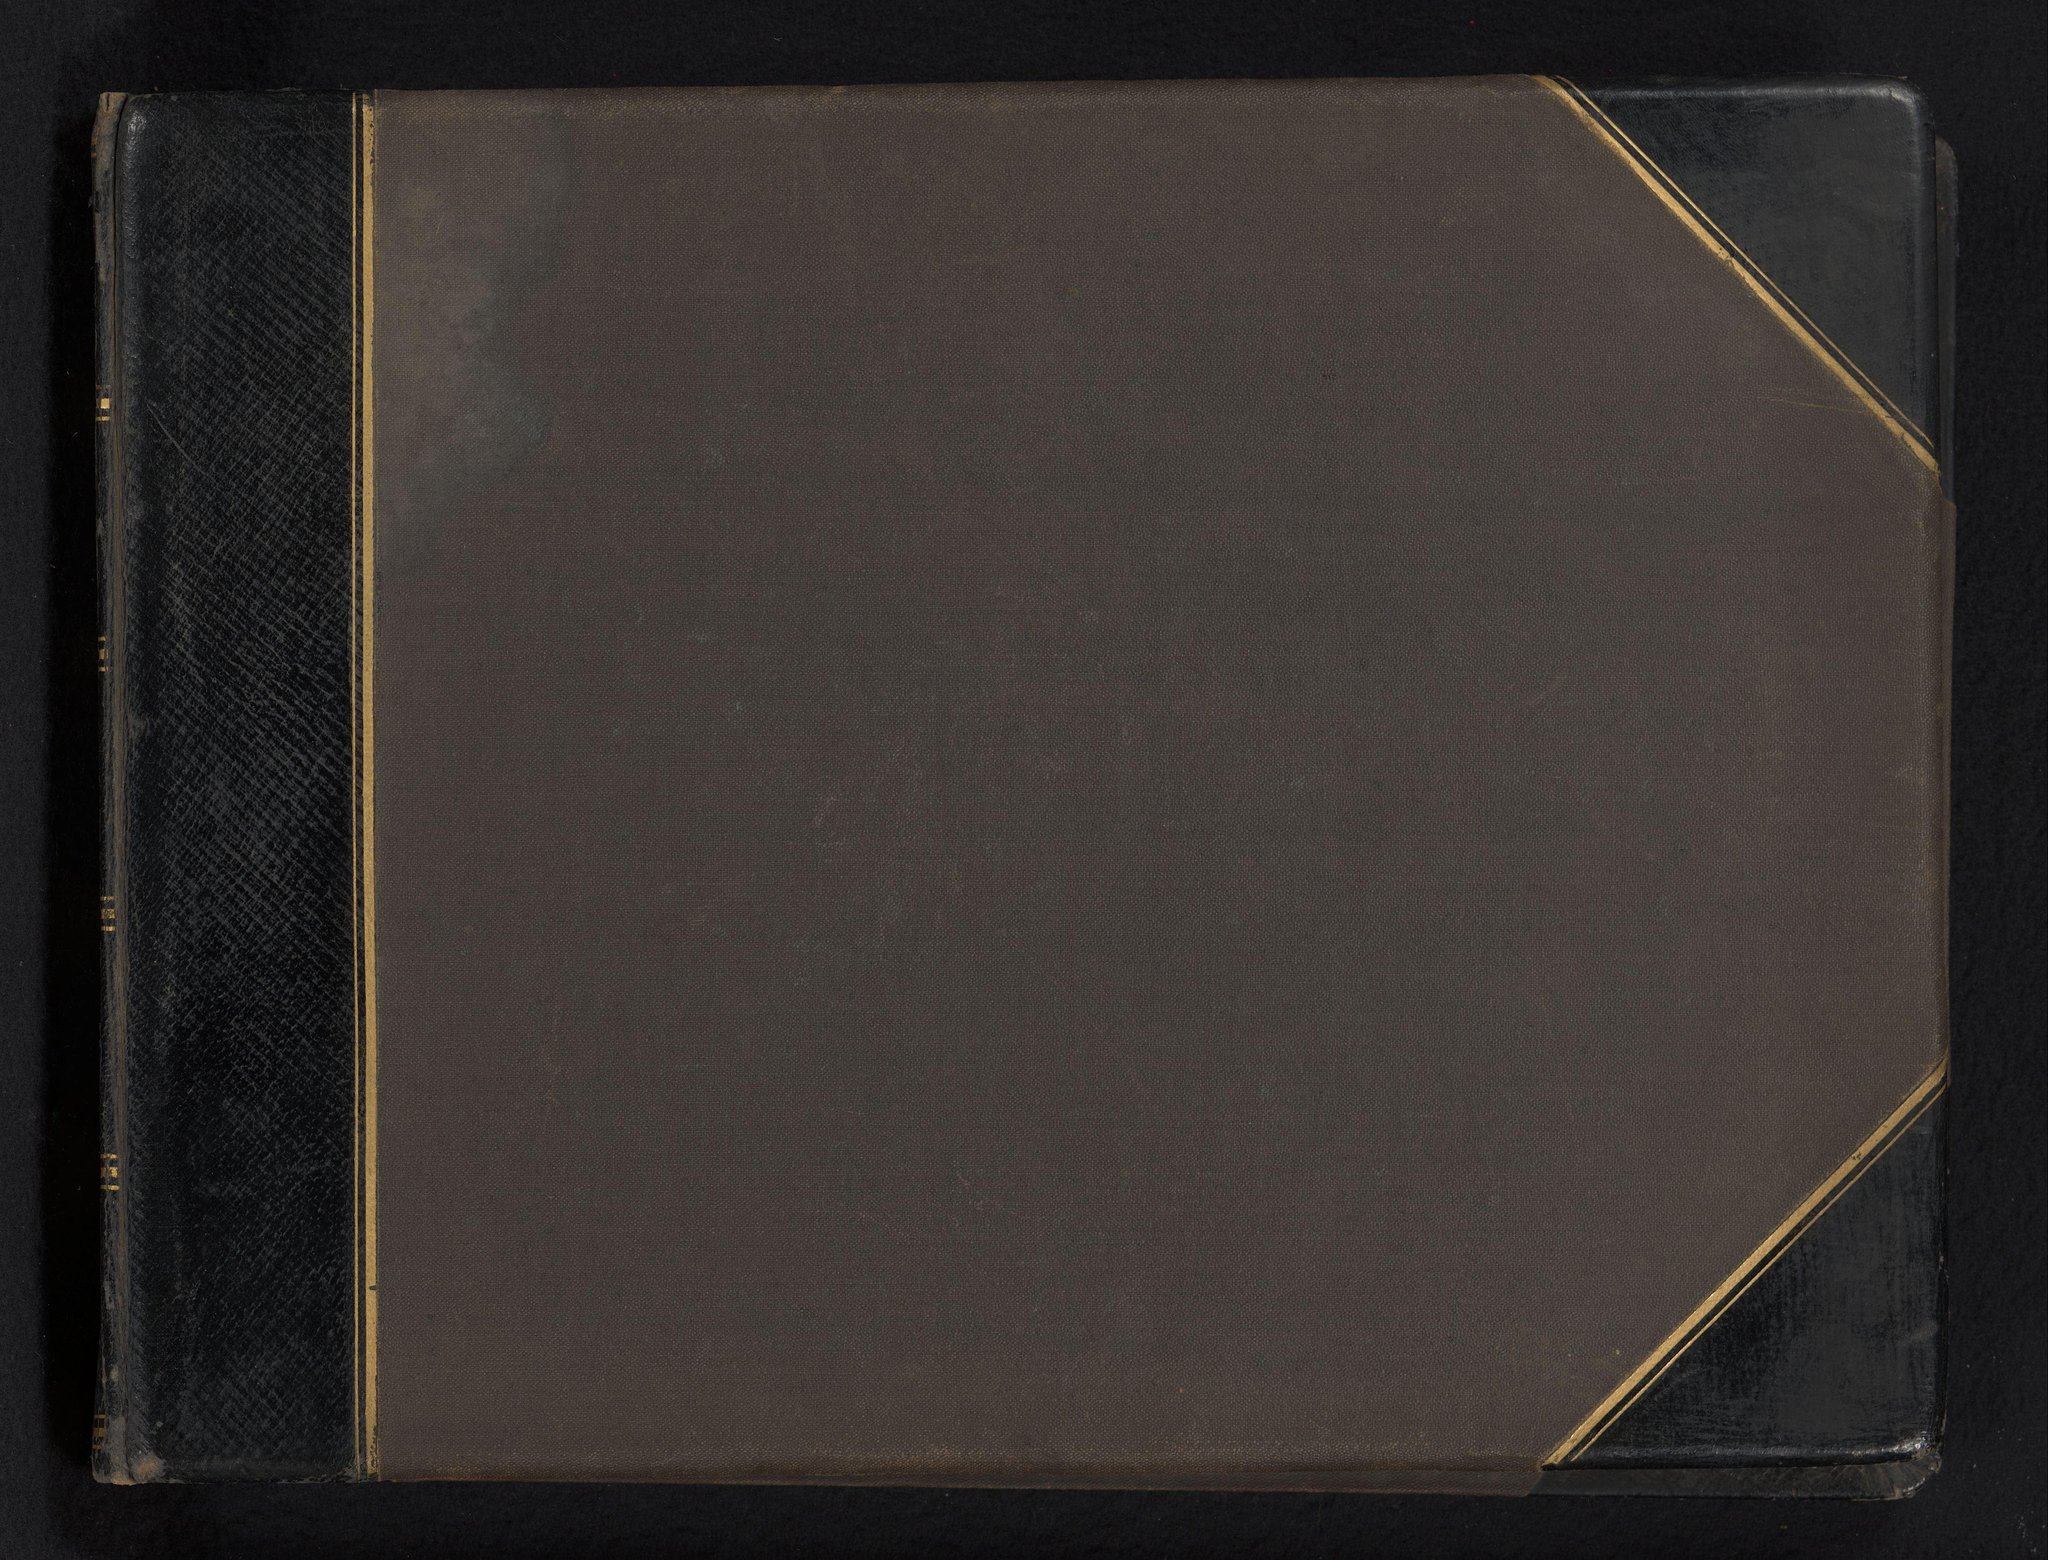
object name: photograph album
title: Reisalbum Frankrijk en Spanje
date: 1880-1900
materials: cardboard, leather, paper, photographic support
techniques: albumen print, painting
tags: city-view in general; 'veduta', castle, river, church (exterior), cloisters ~ monastery, mountains, paris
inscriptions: annotation: ‘foto's/ 16 Parijs/ 66 Frankrijk diverse/ 3 Spanje/ 12 [...]’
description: Fotoalbum met 36 bladen en in totaal 78 foto's, zeven fotomechanische afdrukken en twaalf prenten. De eerste fotomechanische afdruk is op het schutblad geplakt. Het album bevat opnamen van een reis door Frankrijk en Spanje. Het bevat voornamelijk opnamen van gebouwen en landschappen in onder andere Parijs, Chartres, Toulouse, Perpignan, Biarritz, San Sebastian en Bordeaux.